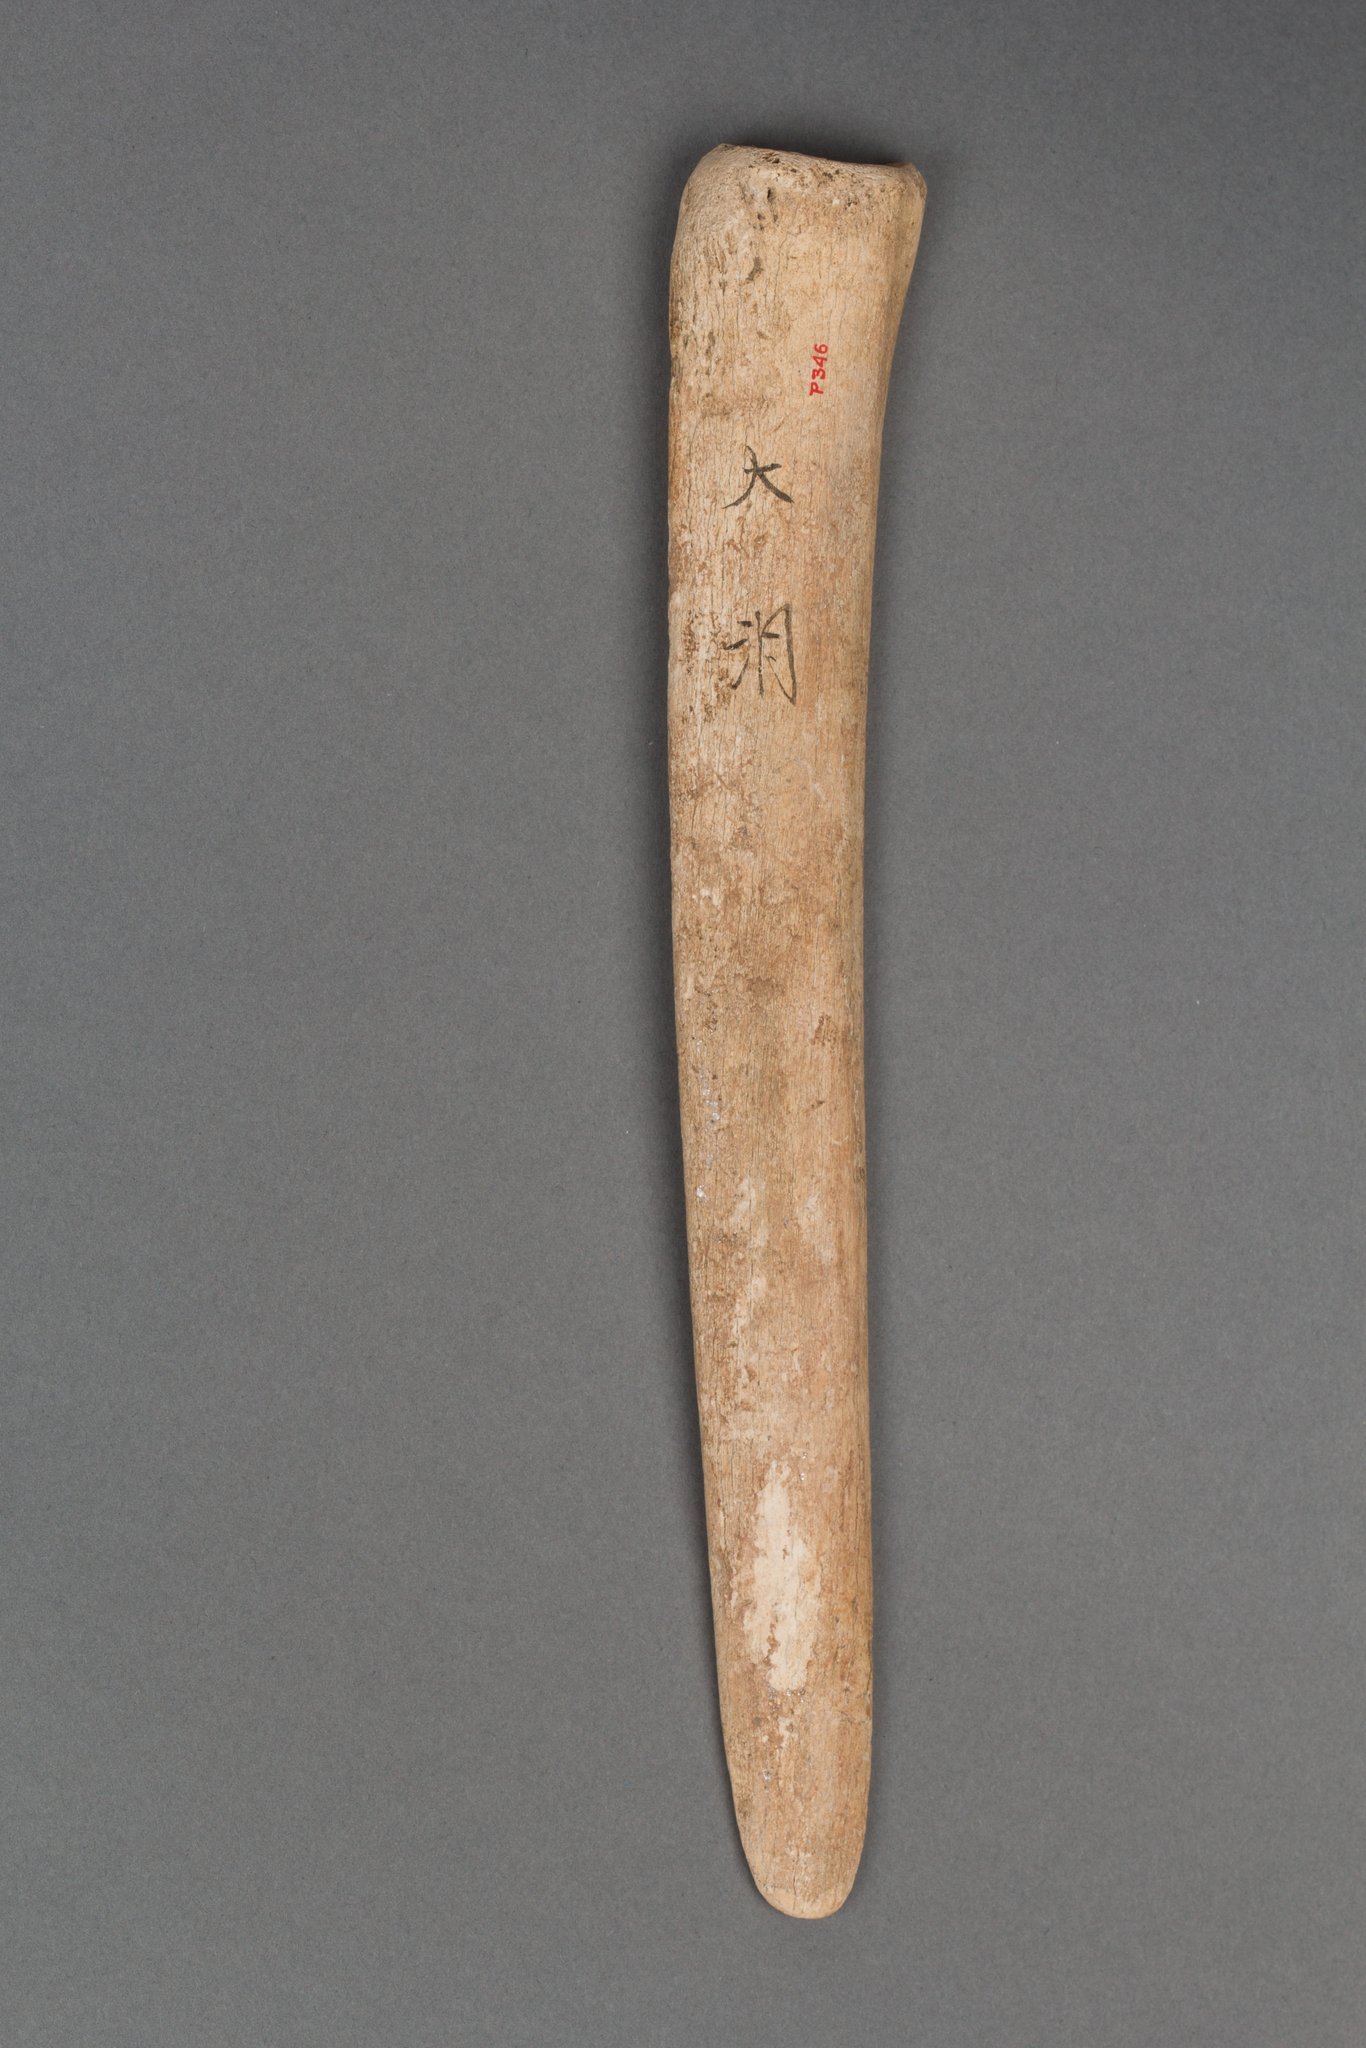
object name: arrowhead, needle, hook and harpoon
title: Arrowheads, needles, hooks and harpoons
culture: japanese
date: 1200-200 BCE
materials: bone